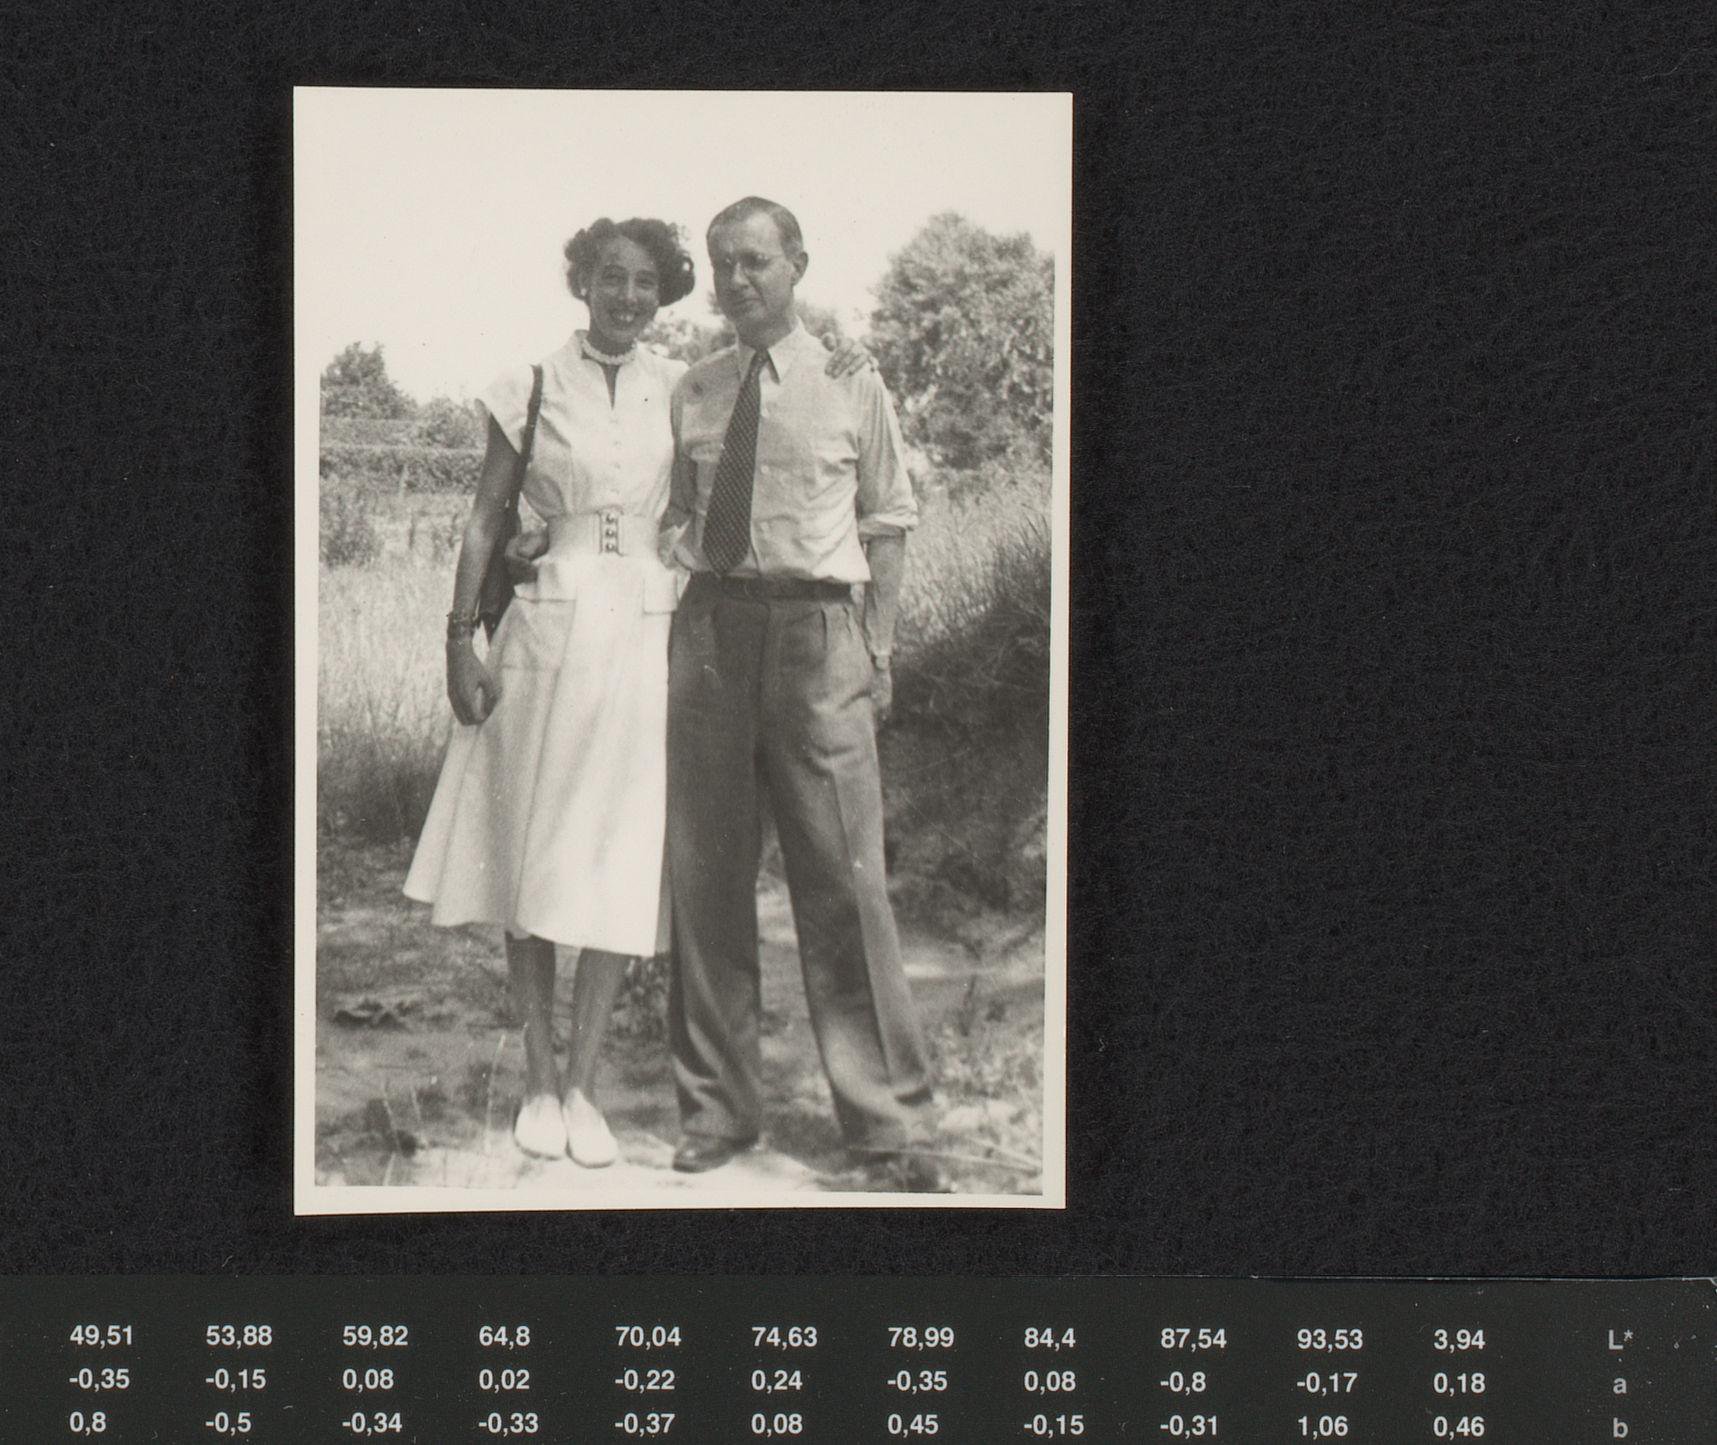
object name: photograph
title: Koenen met echtgenote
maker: Anonymous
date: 1932-1950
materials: photographic support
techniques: gelatin silver print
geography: netherlands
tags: historical persons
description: Koenen met echtgenote. In een aparte envelop met nabestellingen door Koenen bij Fotobureau Ben Zwaan in Den Haag. In envelop met losse foto's behorend bij het fotoalbum over de bewoners van het huis aan de Reguliersgracht te Amsterdam in de periode 1924-1932.